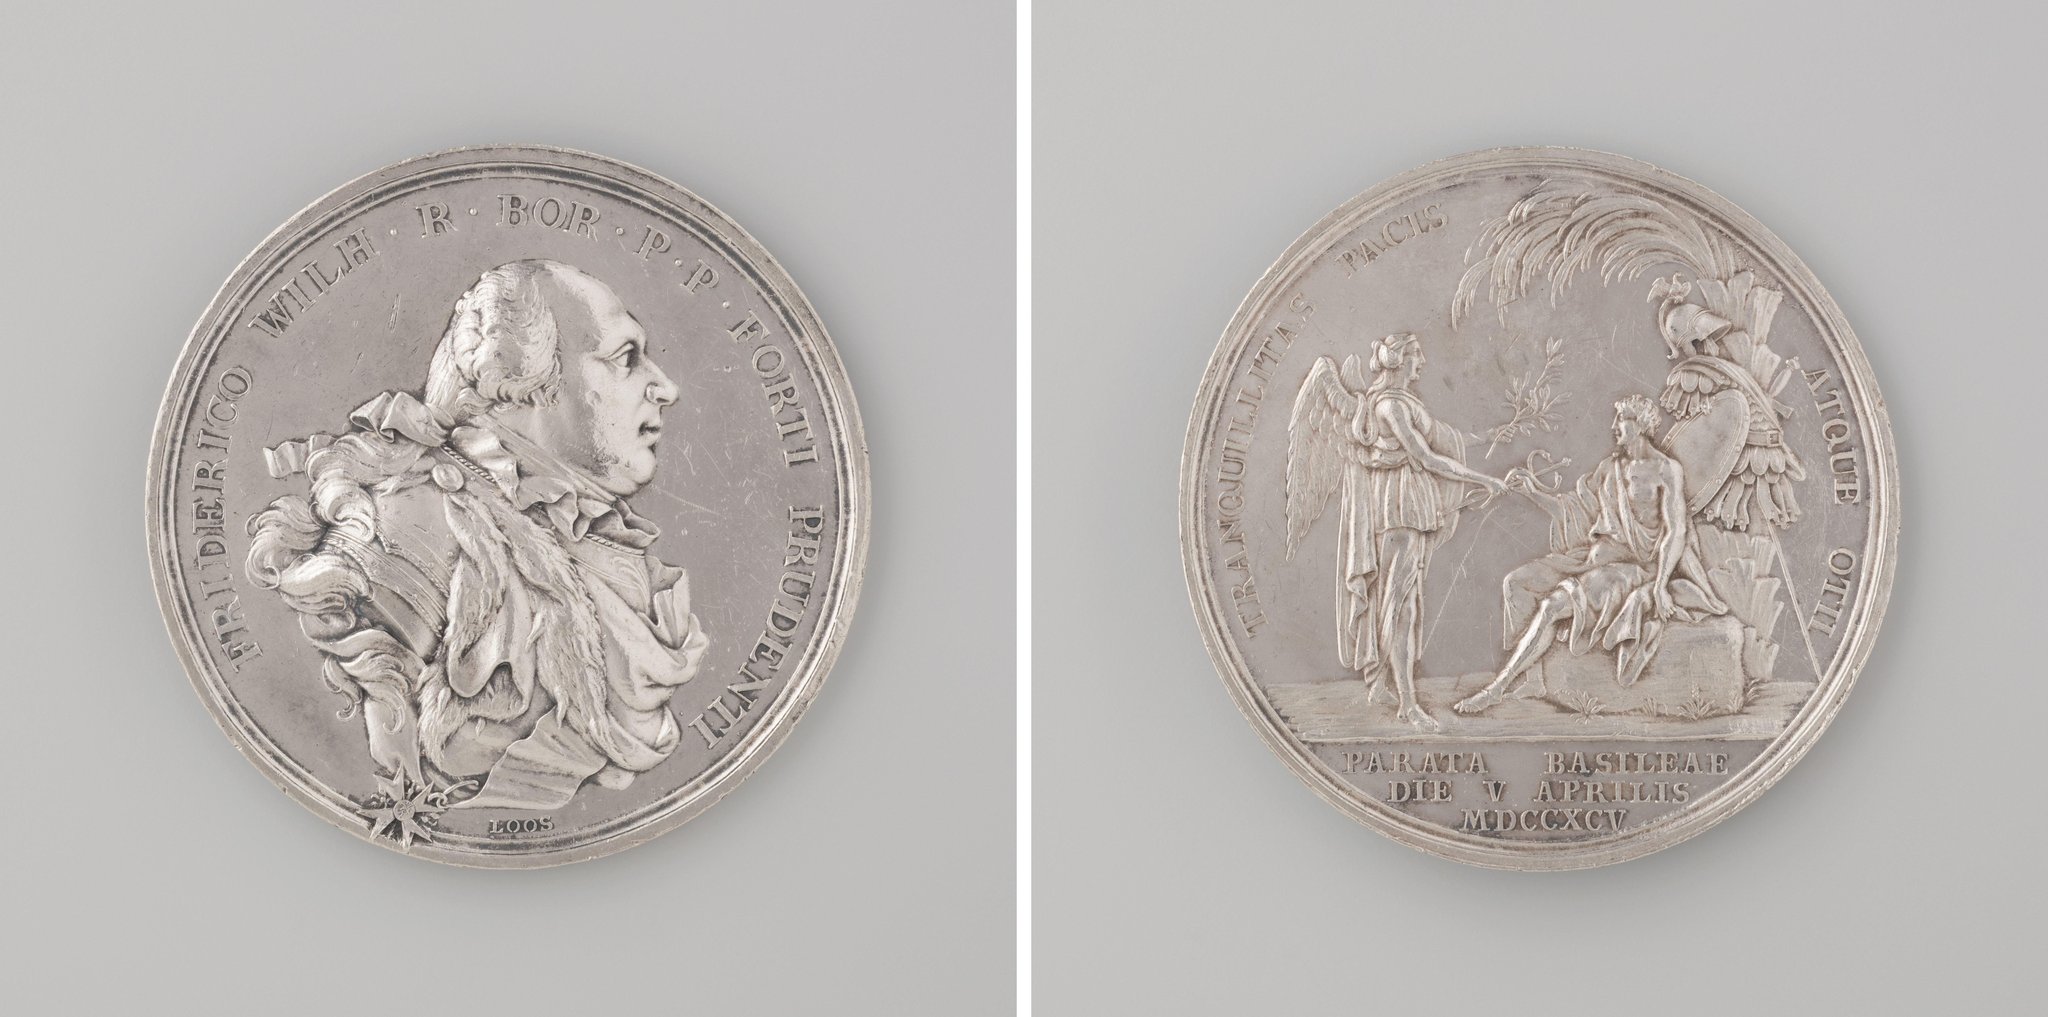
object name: history medal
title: Vrede van Basel, ter ere van Frederik Willem II, koning van Pruisen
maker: daniel friedrich loos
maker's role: medailleur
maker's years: 1735-1819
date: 1795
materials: silver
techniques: striking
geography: berlin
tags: frederik willem ii (koning van pruisen)